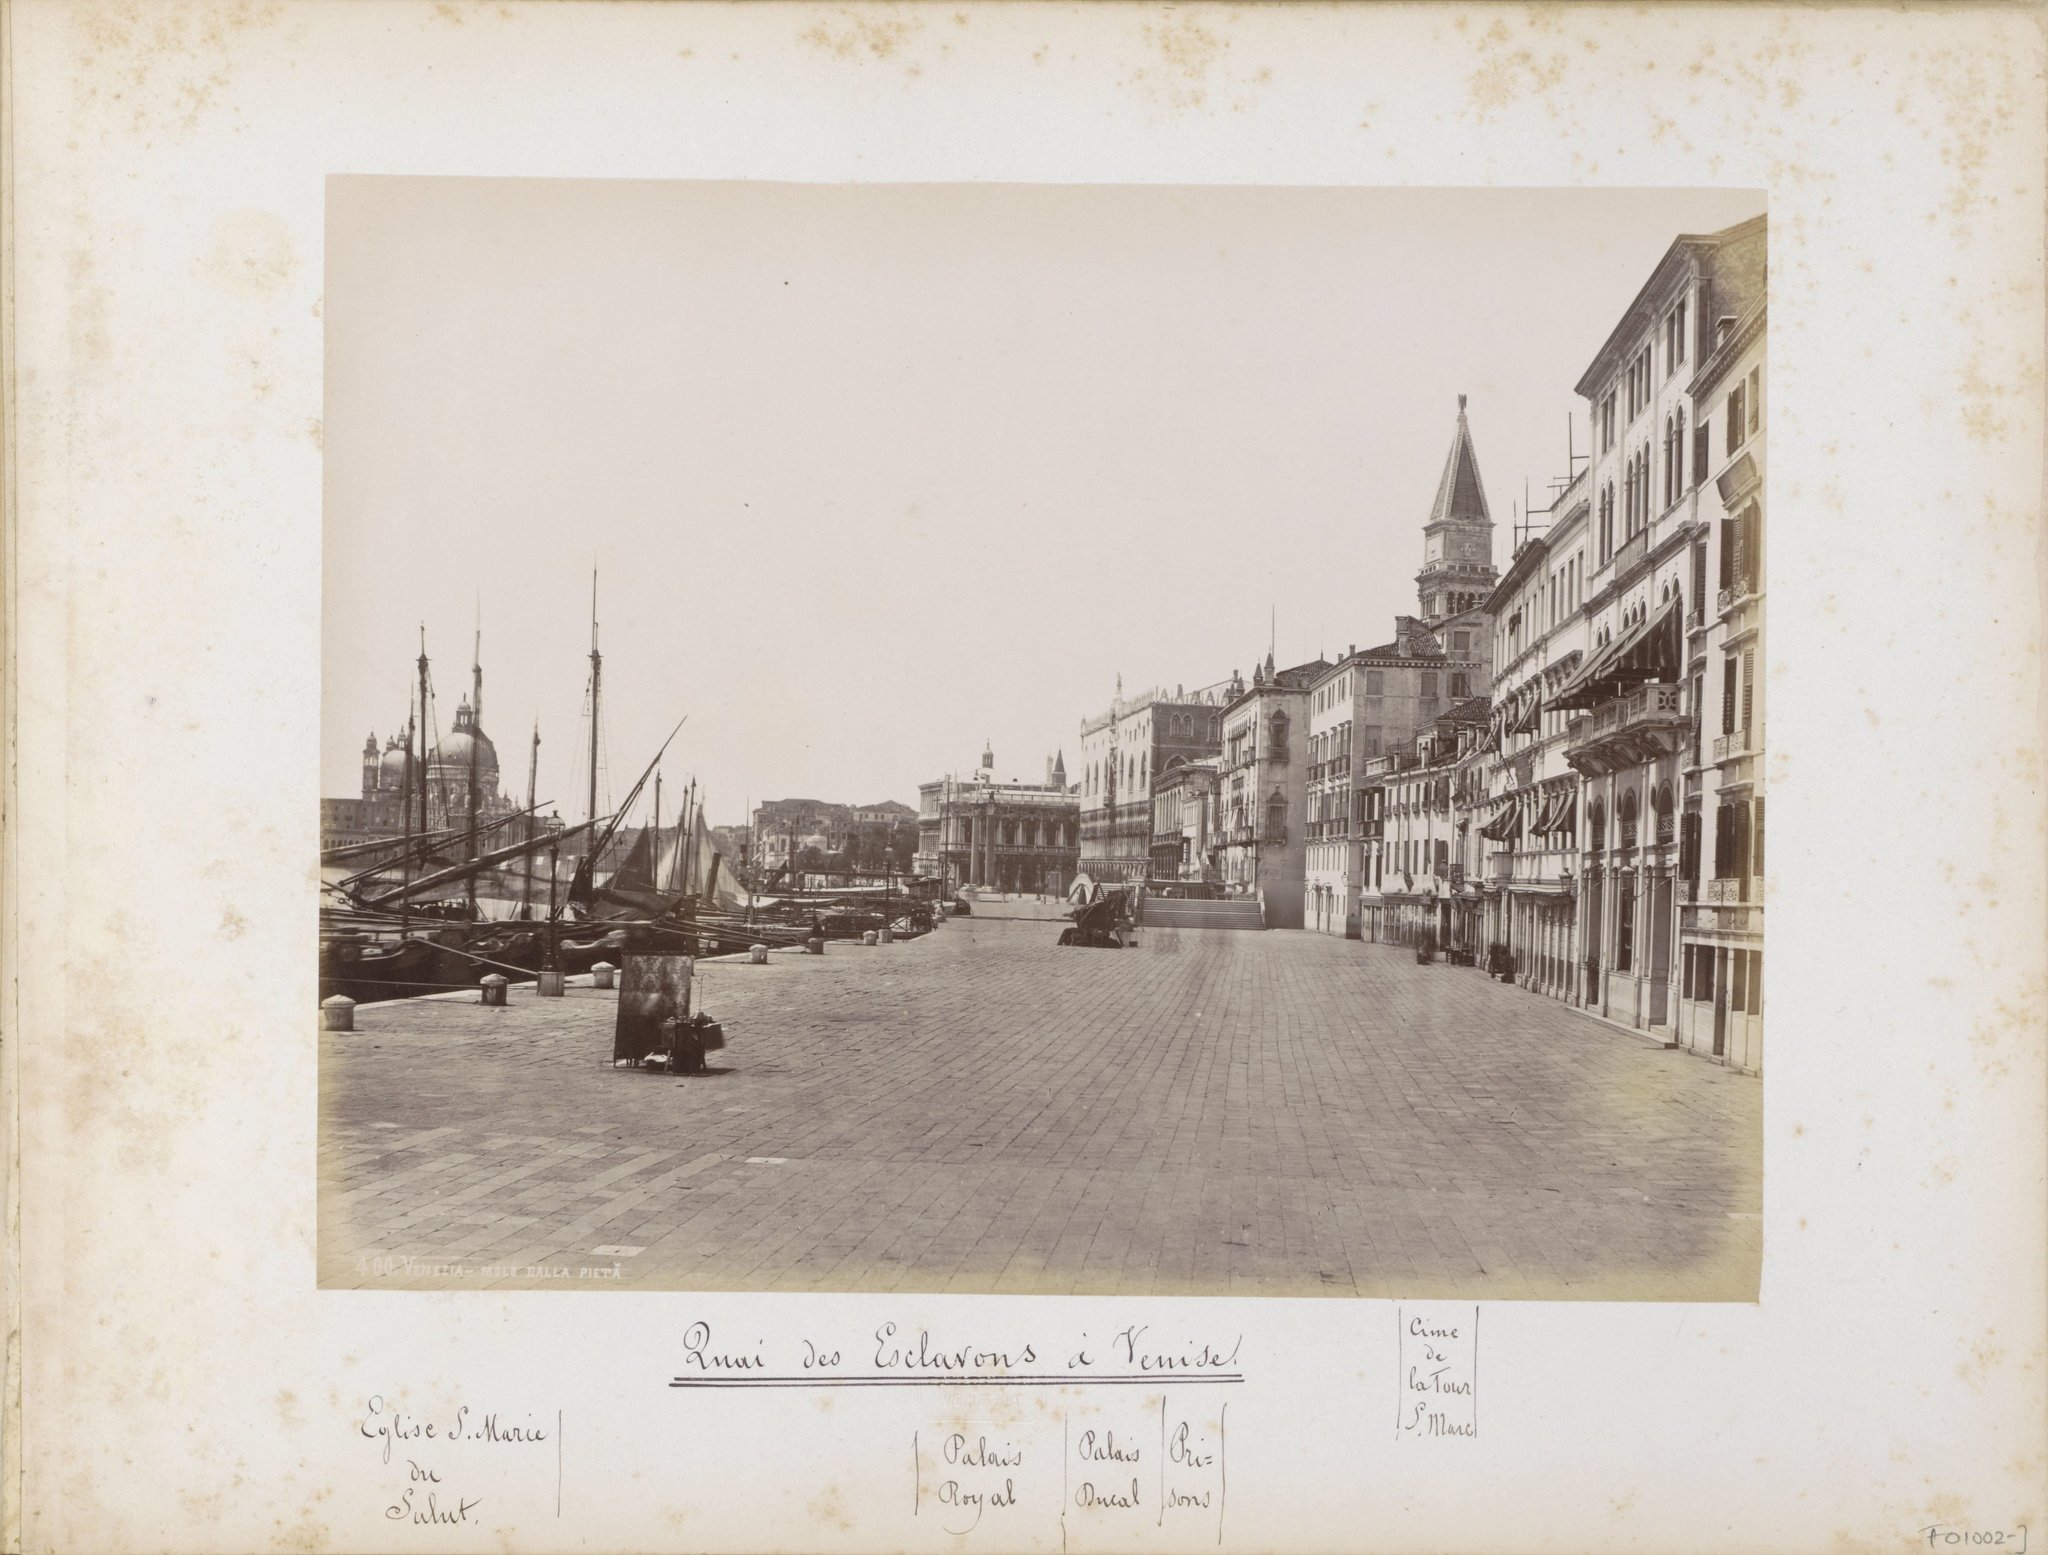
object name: photograph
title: Kade in Venetië gezien in de richting van het San Marcoplein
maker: carlo ponti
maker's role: fotograaf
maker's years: 1820-1893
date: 1860-1881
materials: photographic support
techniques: albumen print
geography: venice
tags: tower, clock tower ~ monumental adornment, roman catholic church, quay (+ city(-scape) with figures, staffage), venice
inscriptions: check stamp: ‘Carlo Ponti Venezia’, negative number: ‘400’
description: Onderdeel van Topografisch album van Venetië 1881.